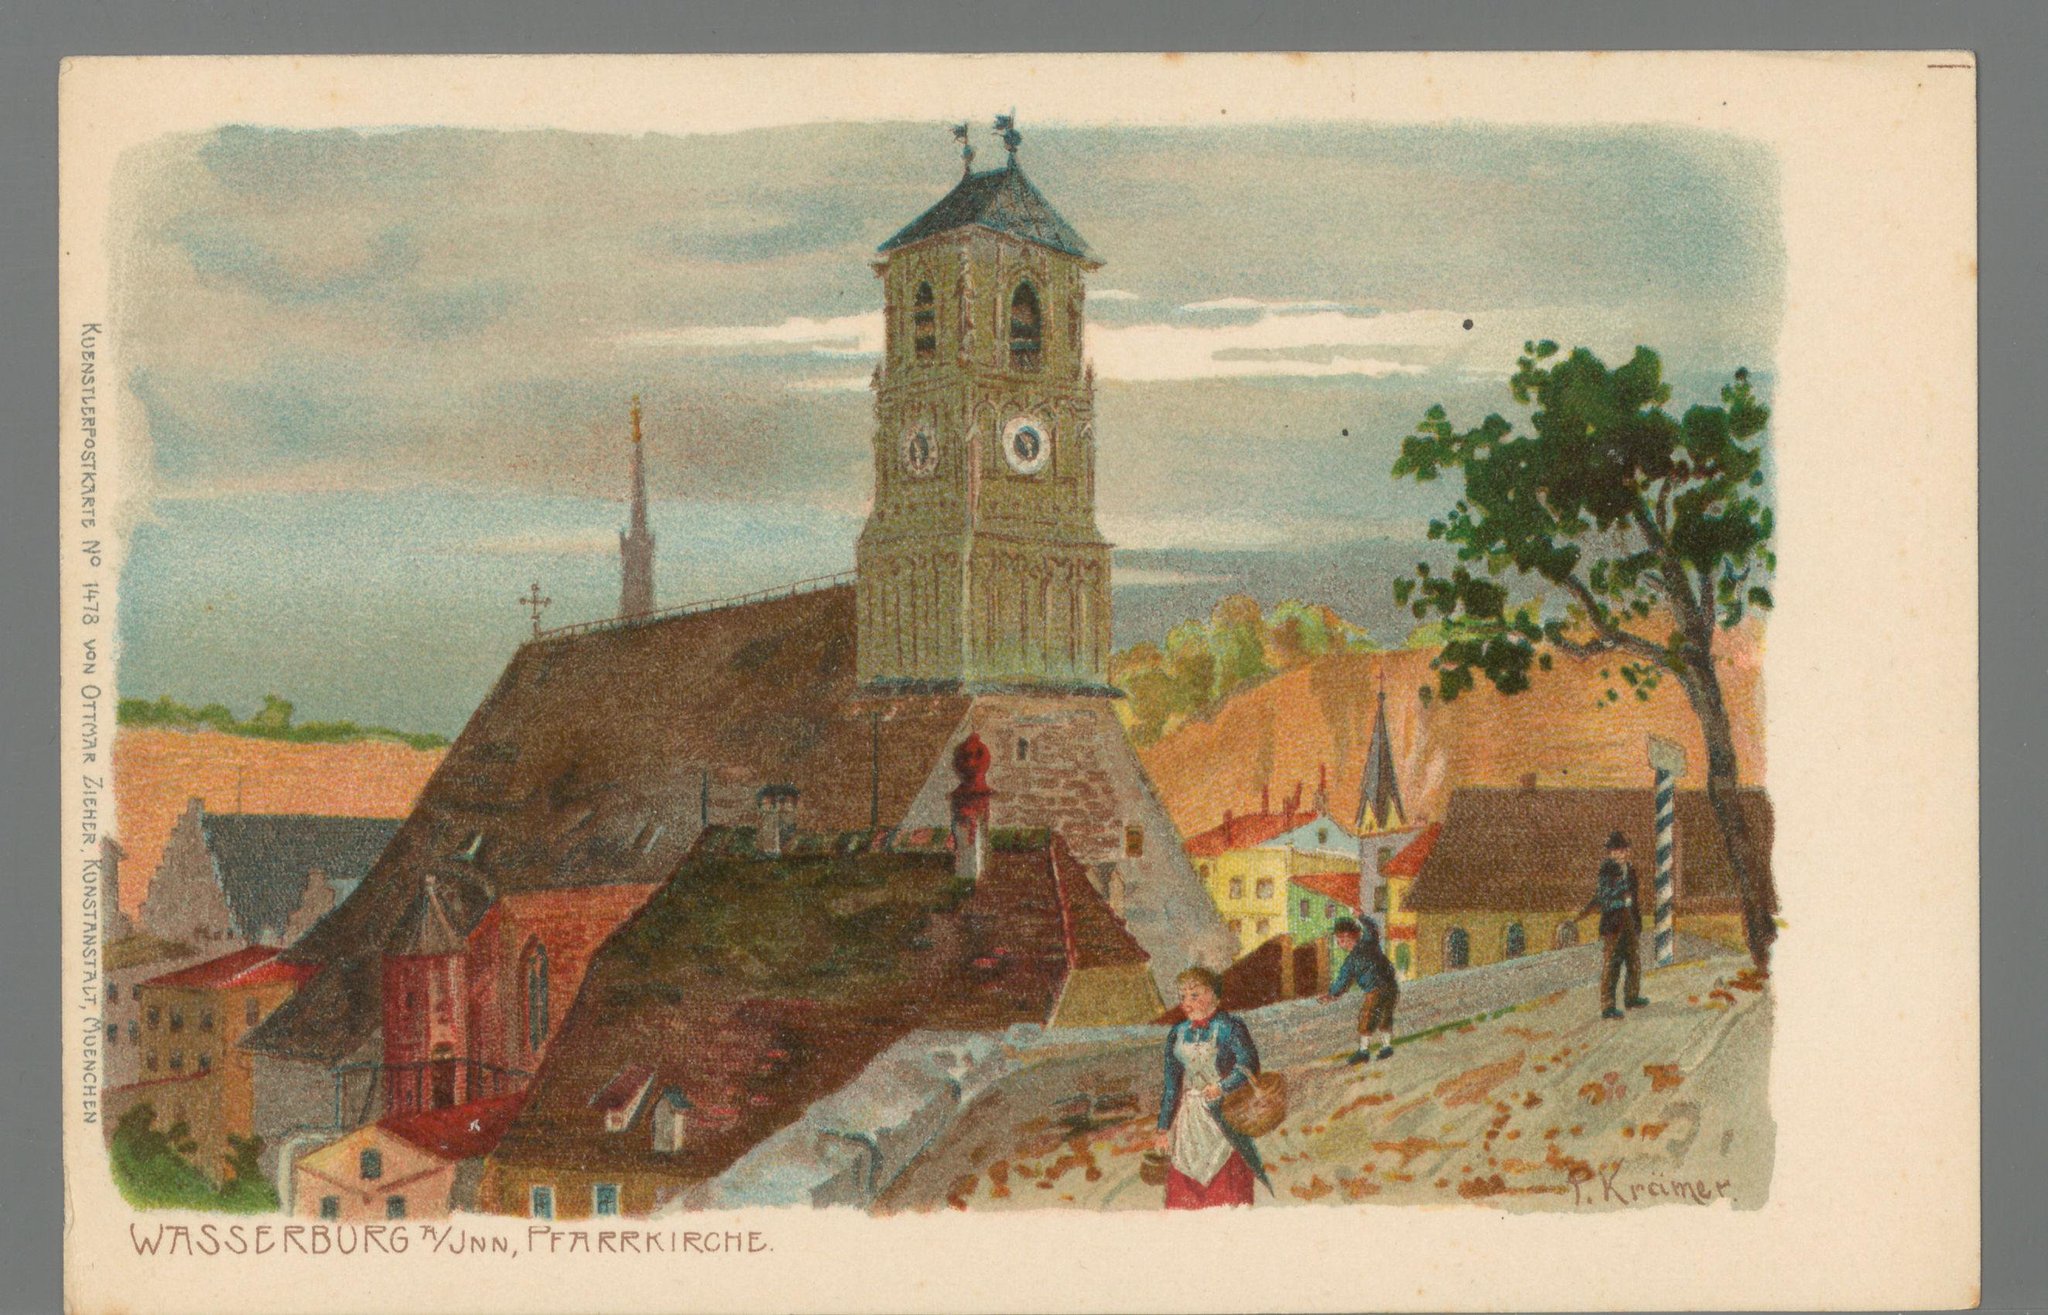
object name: ansichtkaart, prentbriefkaart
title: Wasserburg a/Inn, Pfarrkirche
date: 1900-1905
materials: cardboard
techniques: lithograph, writing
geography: munich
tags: church (exterior)